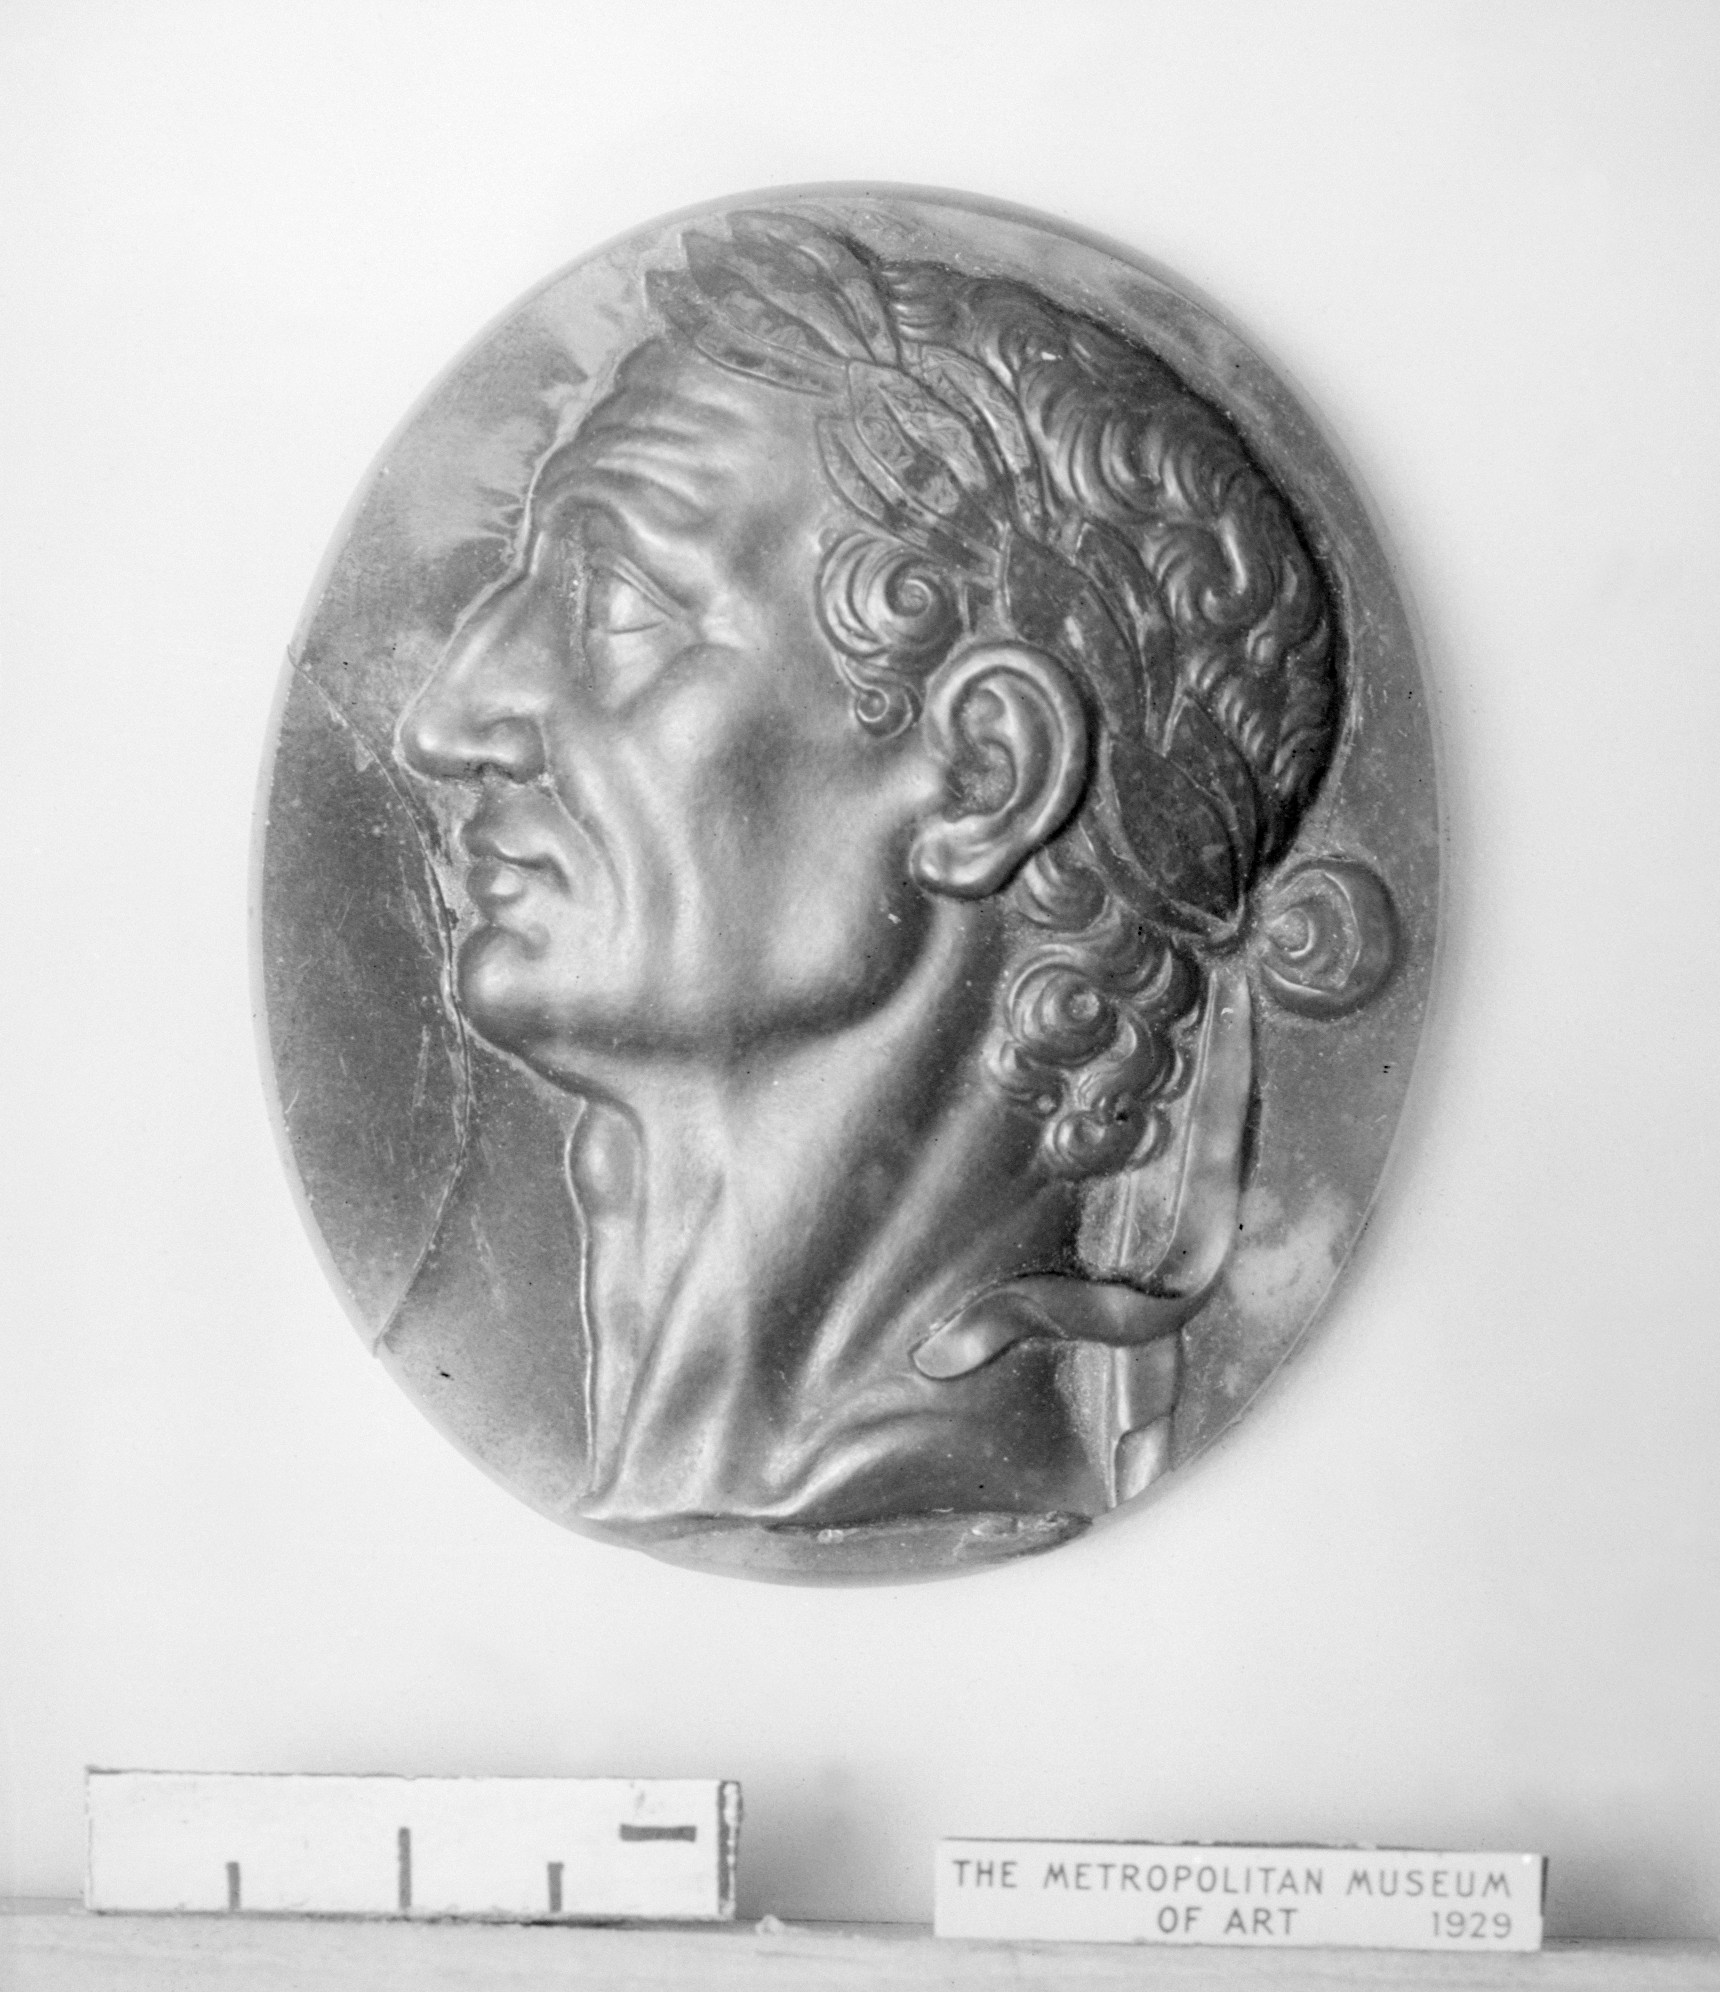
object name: cameo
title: Head of a Roman Emperor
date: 1501-1700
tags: men,profiles